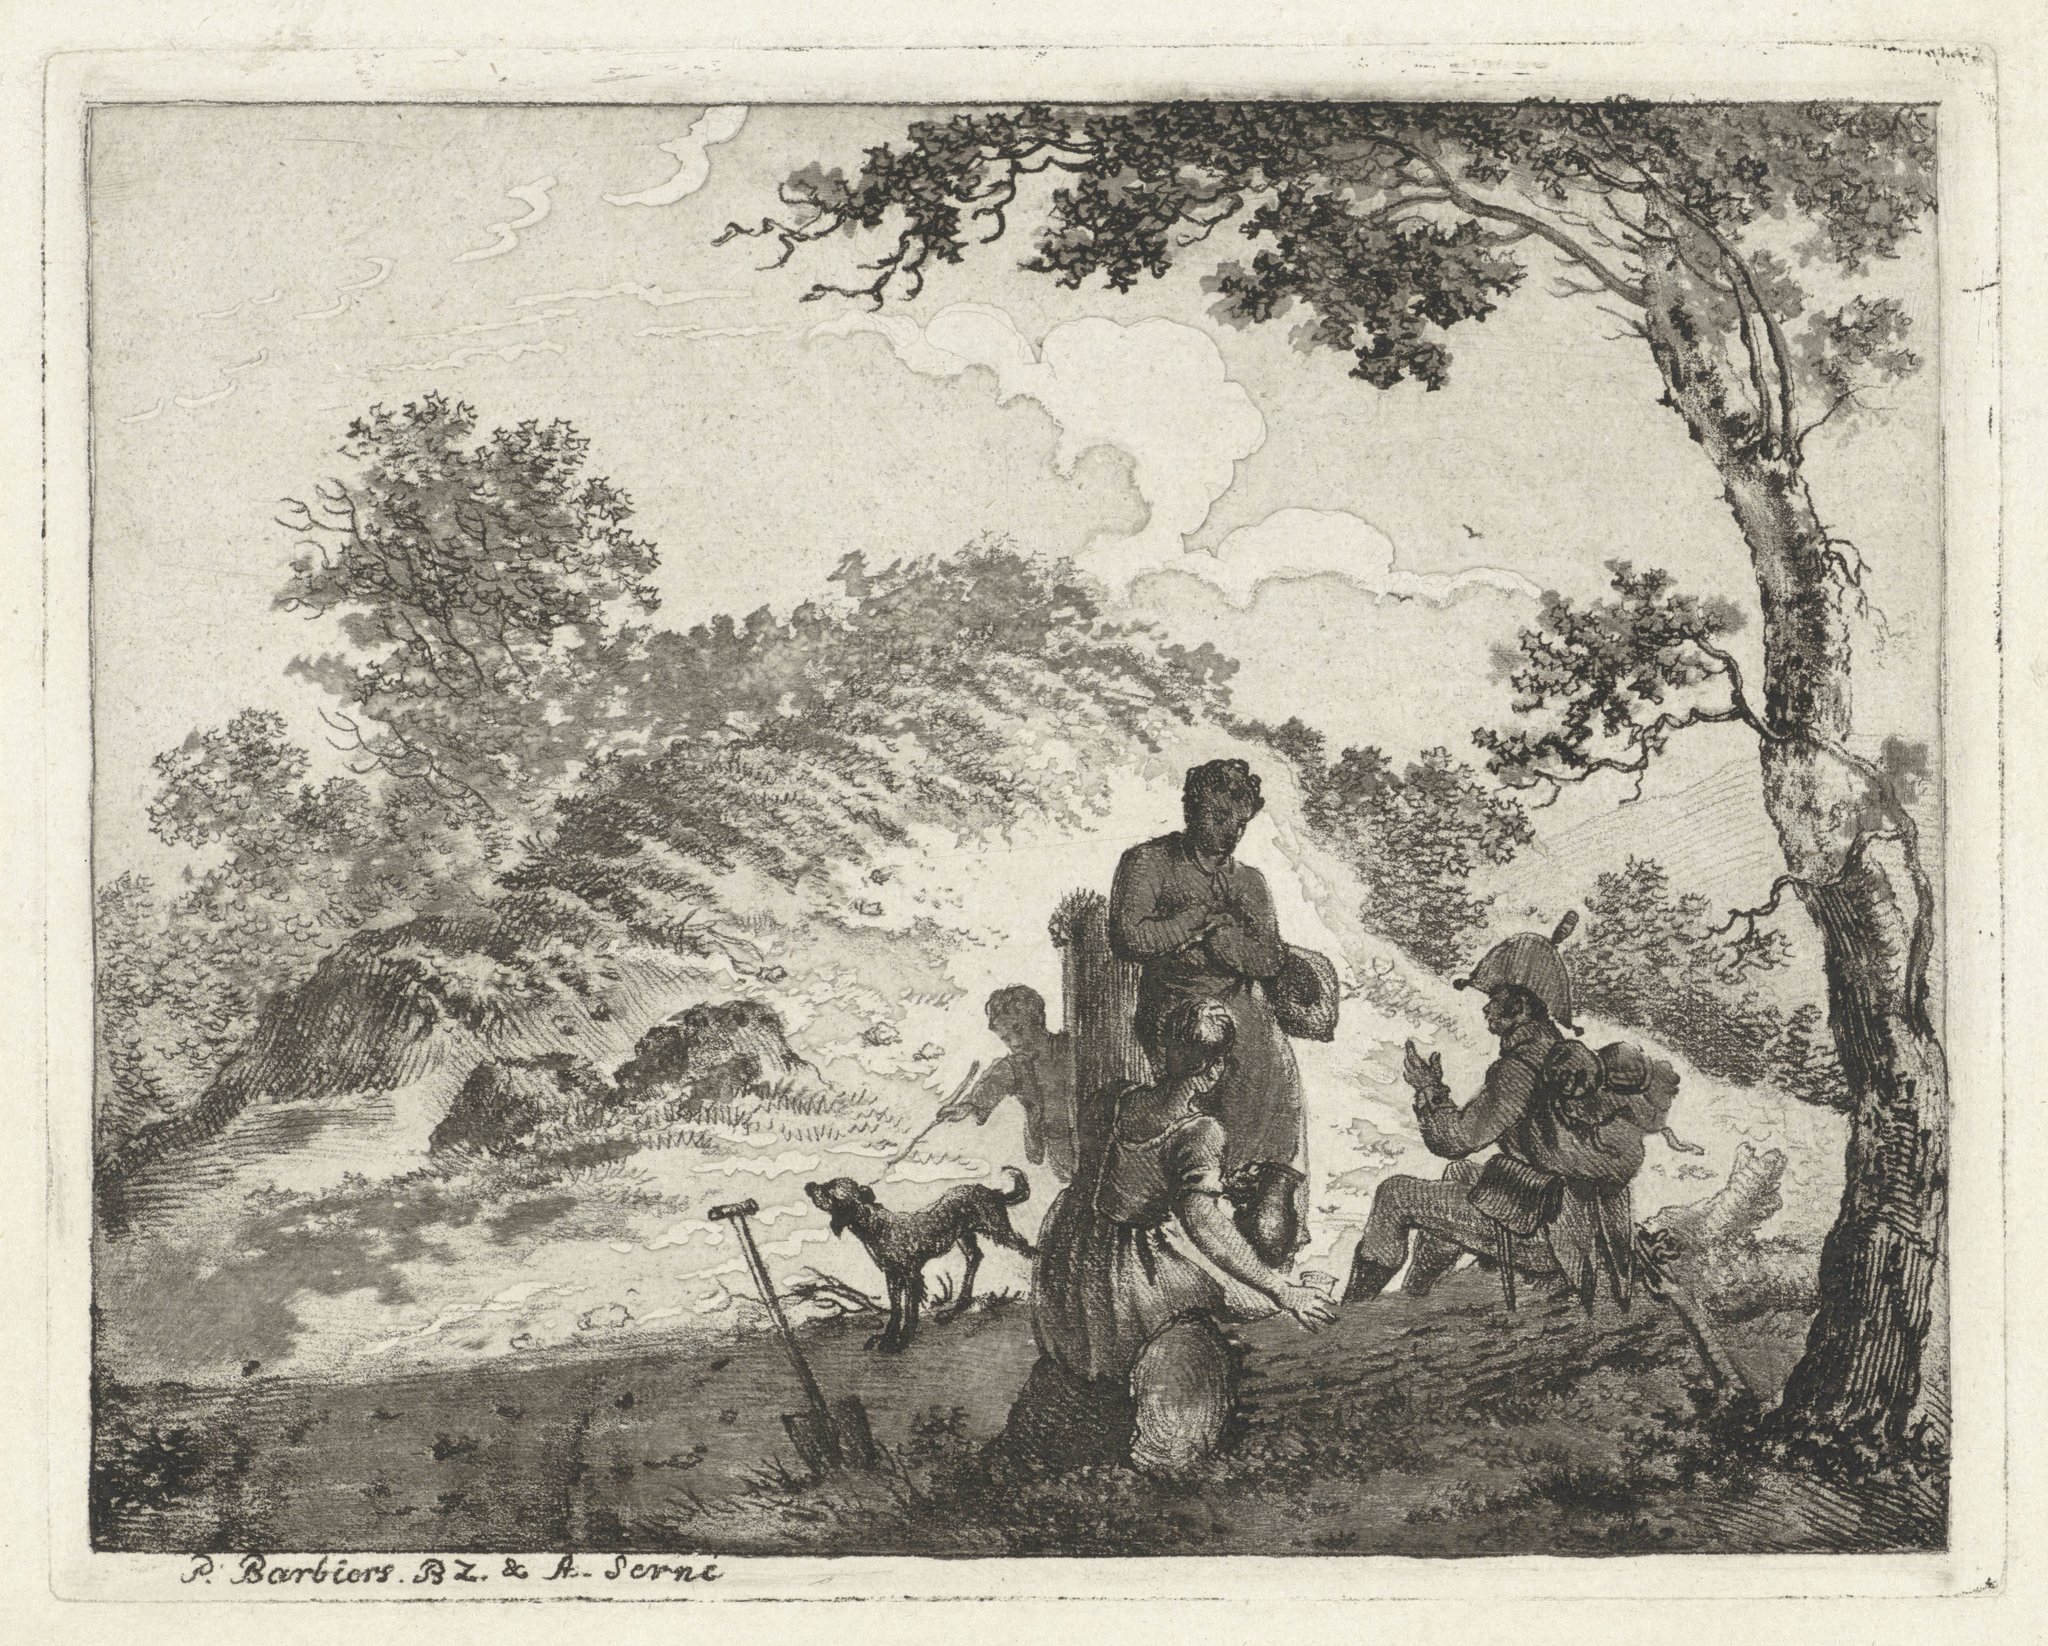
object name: print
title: Rustende figuren bij een boomstam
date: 1783-1853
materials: paper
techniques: aquatint, etching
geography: netherlands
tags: (traveller) resting in the open air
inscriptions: collector's mark: Lugt 2228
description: Een soldaat en een vrouw rusten op een boomstam. De vrouw houdt een kan en een glas in de handen. Bij hen staat een man. Een jongen speelt met een hond.